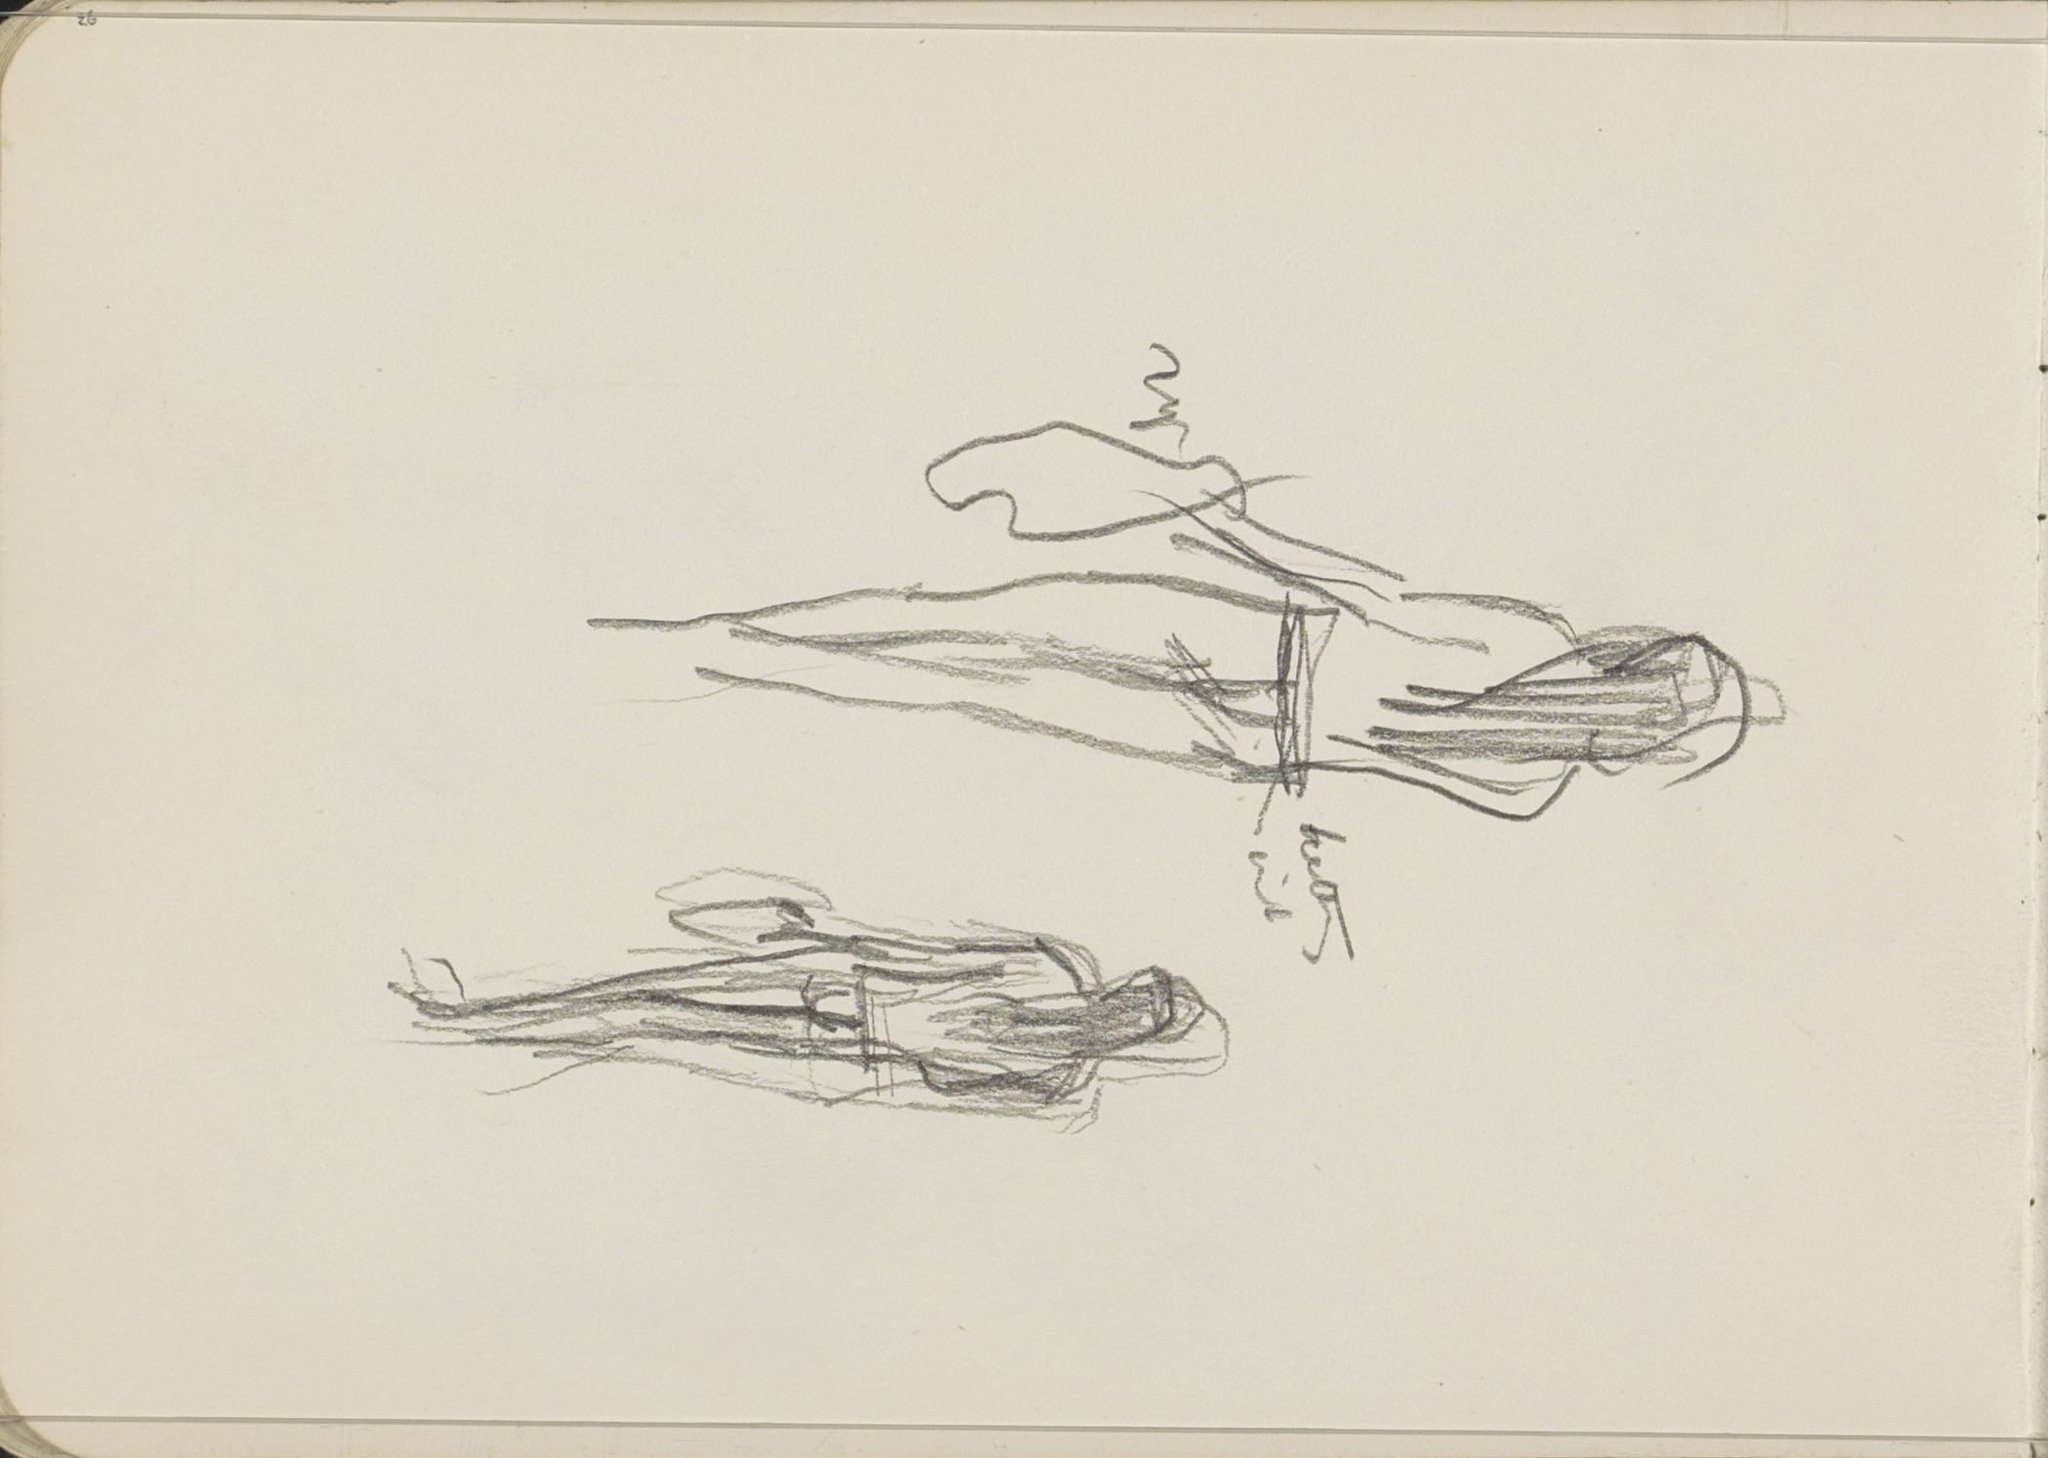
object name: sketchbook leaf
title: Indiër, op de rug gezien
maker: marius bauer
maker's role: draughtsman, print maker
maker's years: 1867-1932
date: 1924-1925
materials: paper, pencil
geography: india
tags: standing figure, asiatic races and peoples: indians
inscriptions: kleurnotitie, handgeschreven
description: De man heeft het bovenlijf ontbloot en draagt een doek om zijn middel. Pagina 26 uit een schetsboek met 23 bladen.